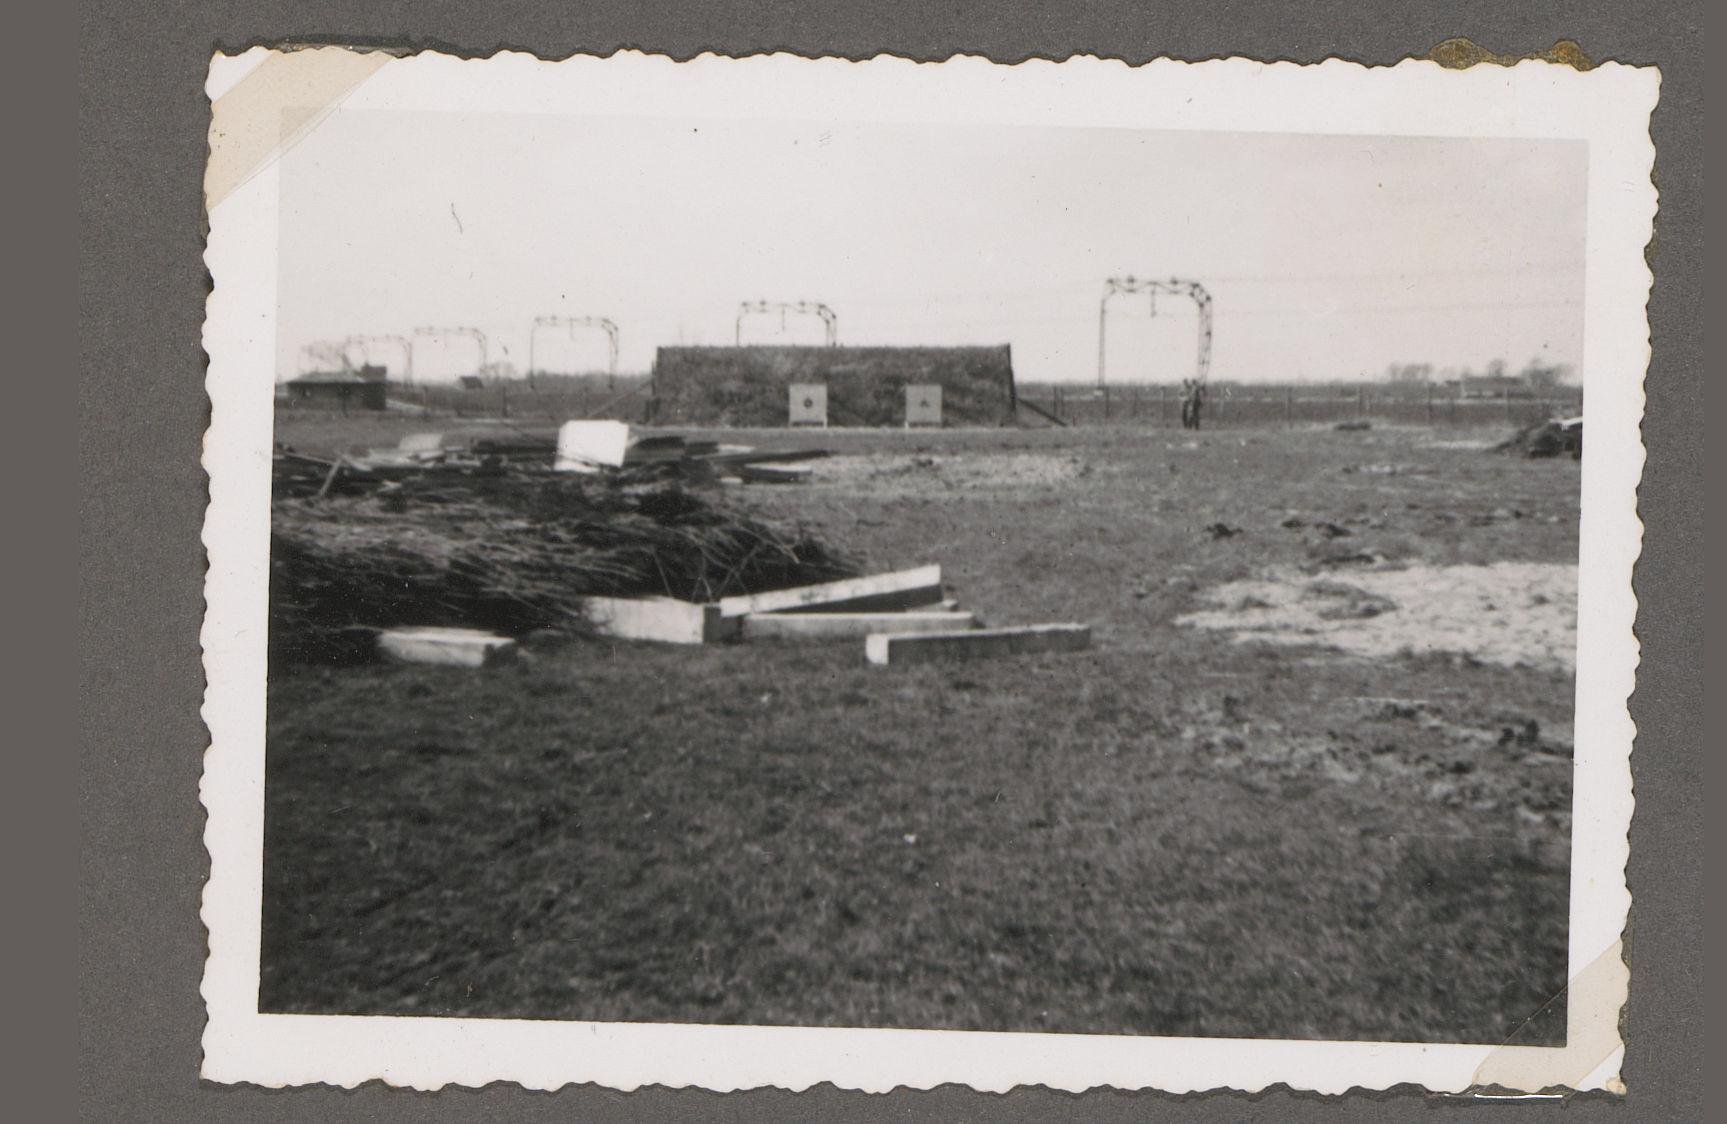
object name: photograph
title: Schietoefening te Vlaardingen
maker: Anonymous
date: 1935-1945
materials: paper, photographic support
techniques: gelatin silver print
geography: vlaardingen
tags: military training (+ cavalry, horsemen), the soldier; the soldier's life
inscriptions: annotation: ‘Beim Schießendes U-stabes in Vlaardingen’